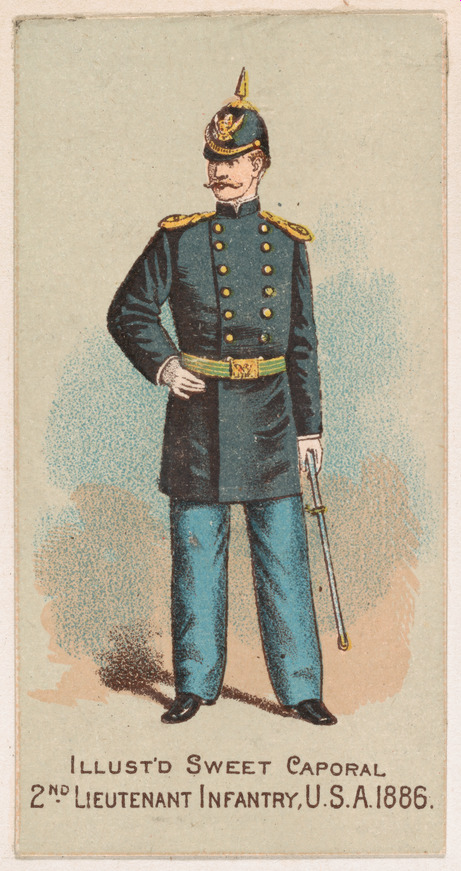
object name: print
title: Second Lieutenant Infantry, United States Army, 1886, from the Military Series (N224) issued by Kinney Tobacco Company to promote Sweet Caporal Cigarettes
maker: kinney brothers tobacco company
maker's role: publisher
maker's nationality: american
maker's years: 1869-2011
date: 1888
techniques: color lithograph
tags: military,men